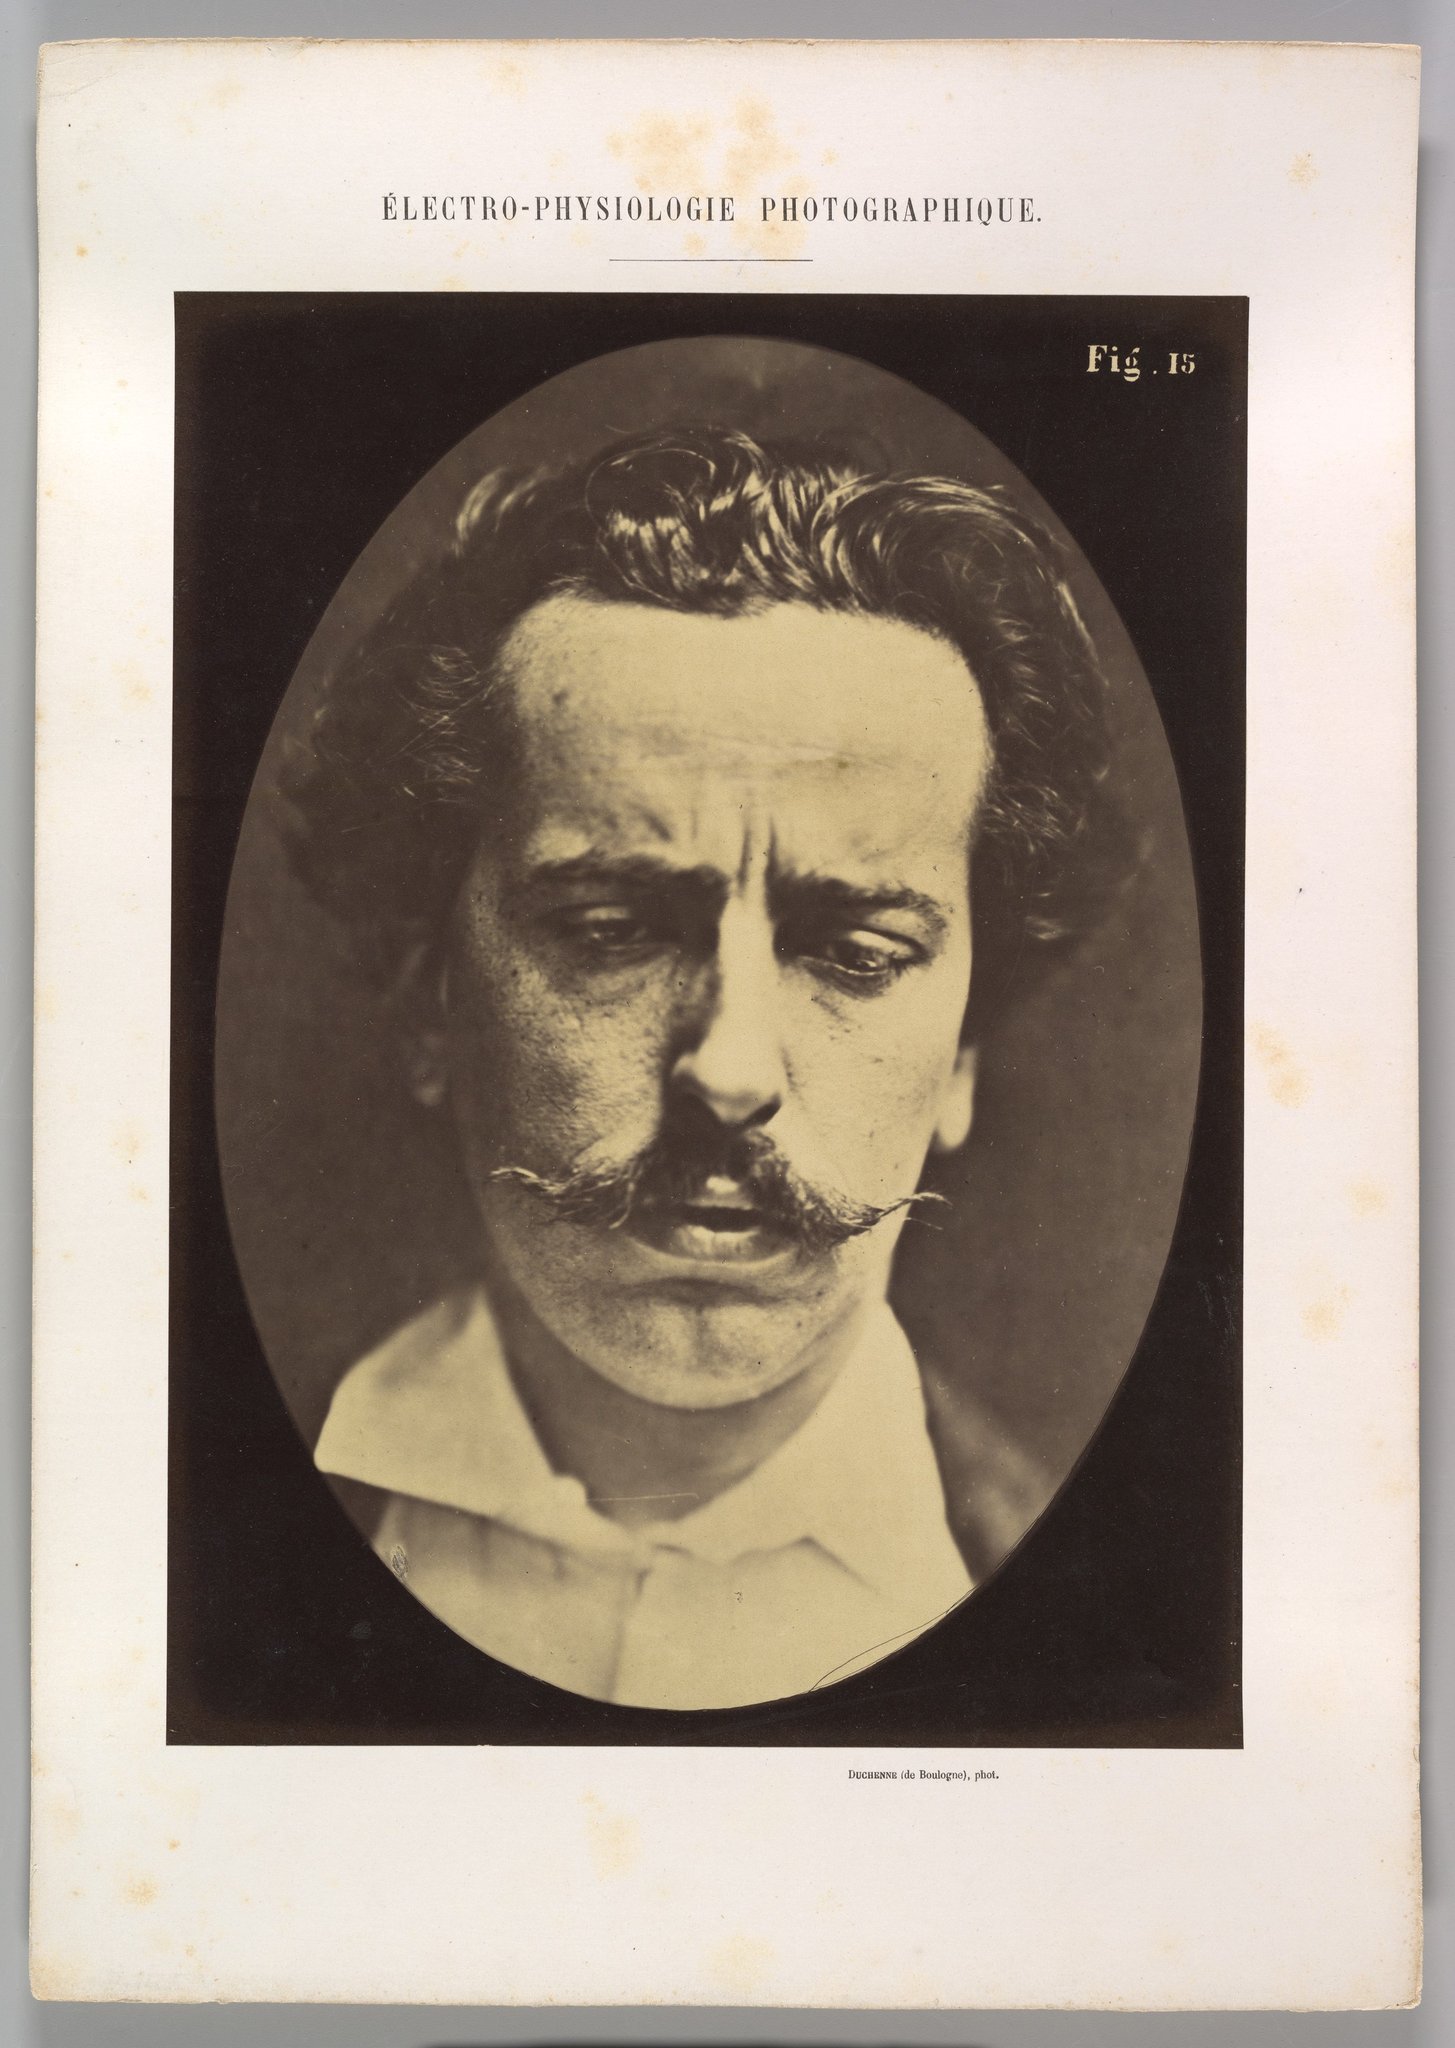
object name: photograph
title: Figure 15: Mediation, mental concentration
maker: guillaume-benjamin-amand duchenne de boulogne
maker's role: artist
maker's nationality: french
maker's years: 1806-1875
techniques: albumen silver print, glass negative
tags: science,men,portraits